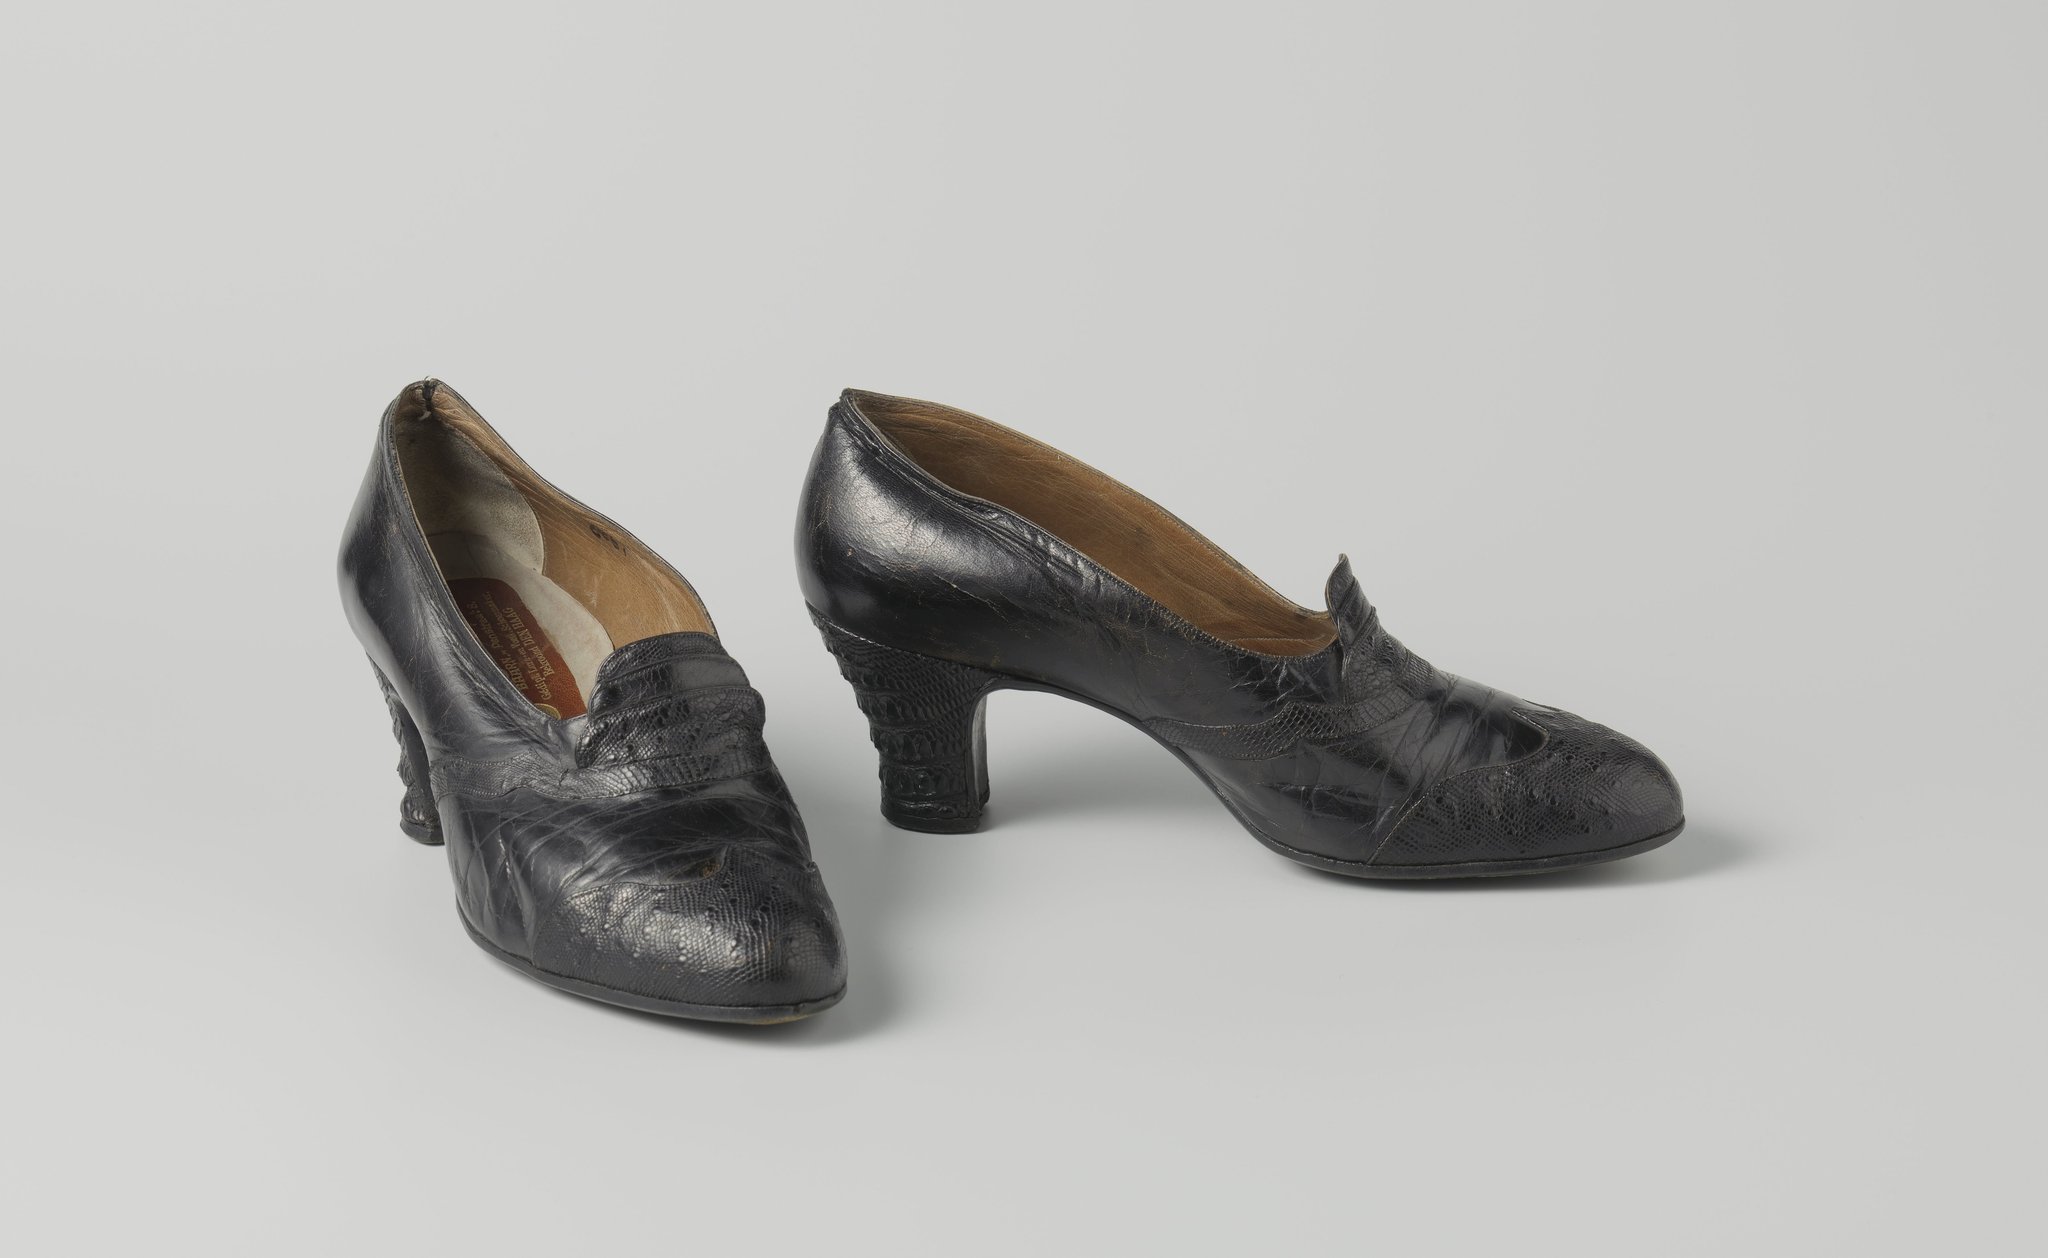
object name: damesschoen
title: Damesschoen van zwart leer versierd met zwart reptielleer en opstaande klep op de wreef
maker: h.j. van gaver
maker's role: schoenmaker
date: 1940-1950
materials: leather, metal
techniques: tanning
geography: baarn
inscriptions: company name: ‘H. J. van Graver // BAARN. - penstraat 8. // Gédipl. pl. Luxe- en voetk. Schoenmaker. // Bekroond DEN HAAG’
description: Damesschoen van zwart leer met opstaande klep op de wreef. Afgeronde neus, blad uit één stuk leer. De voorkant van de hak loopt in een afgeronde hoek recht naar beneden. De zijkant en achterkant van de hak zijn iets getailleerd en bekleed met zwart reptielleer. Leren achterlapje met drie spijkers aan de hak vastgeslagen en leren zool. Blad gevoerd met bruin leer. Hiel gevoerd met geruwd ivoorwit leer. De binnenzool is van grijs leer. Versiering: Op de neus versierd met stuk reptielleer. Langs de schachtrand een golvende rand reptielleer. Op de opstaande klep twee banden reptielleer.